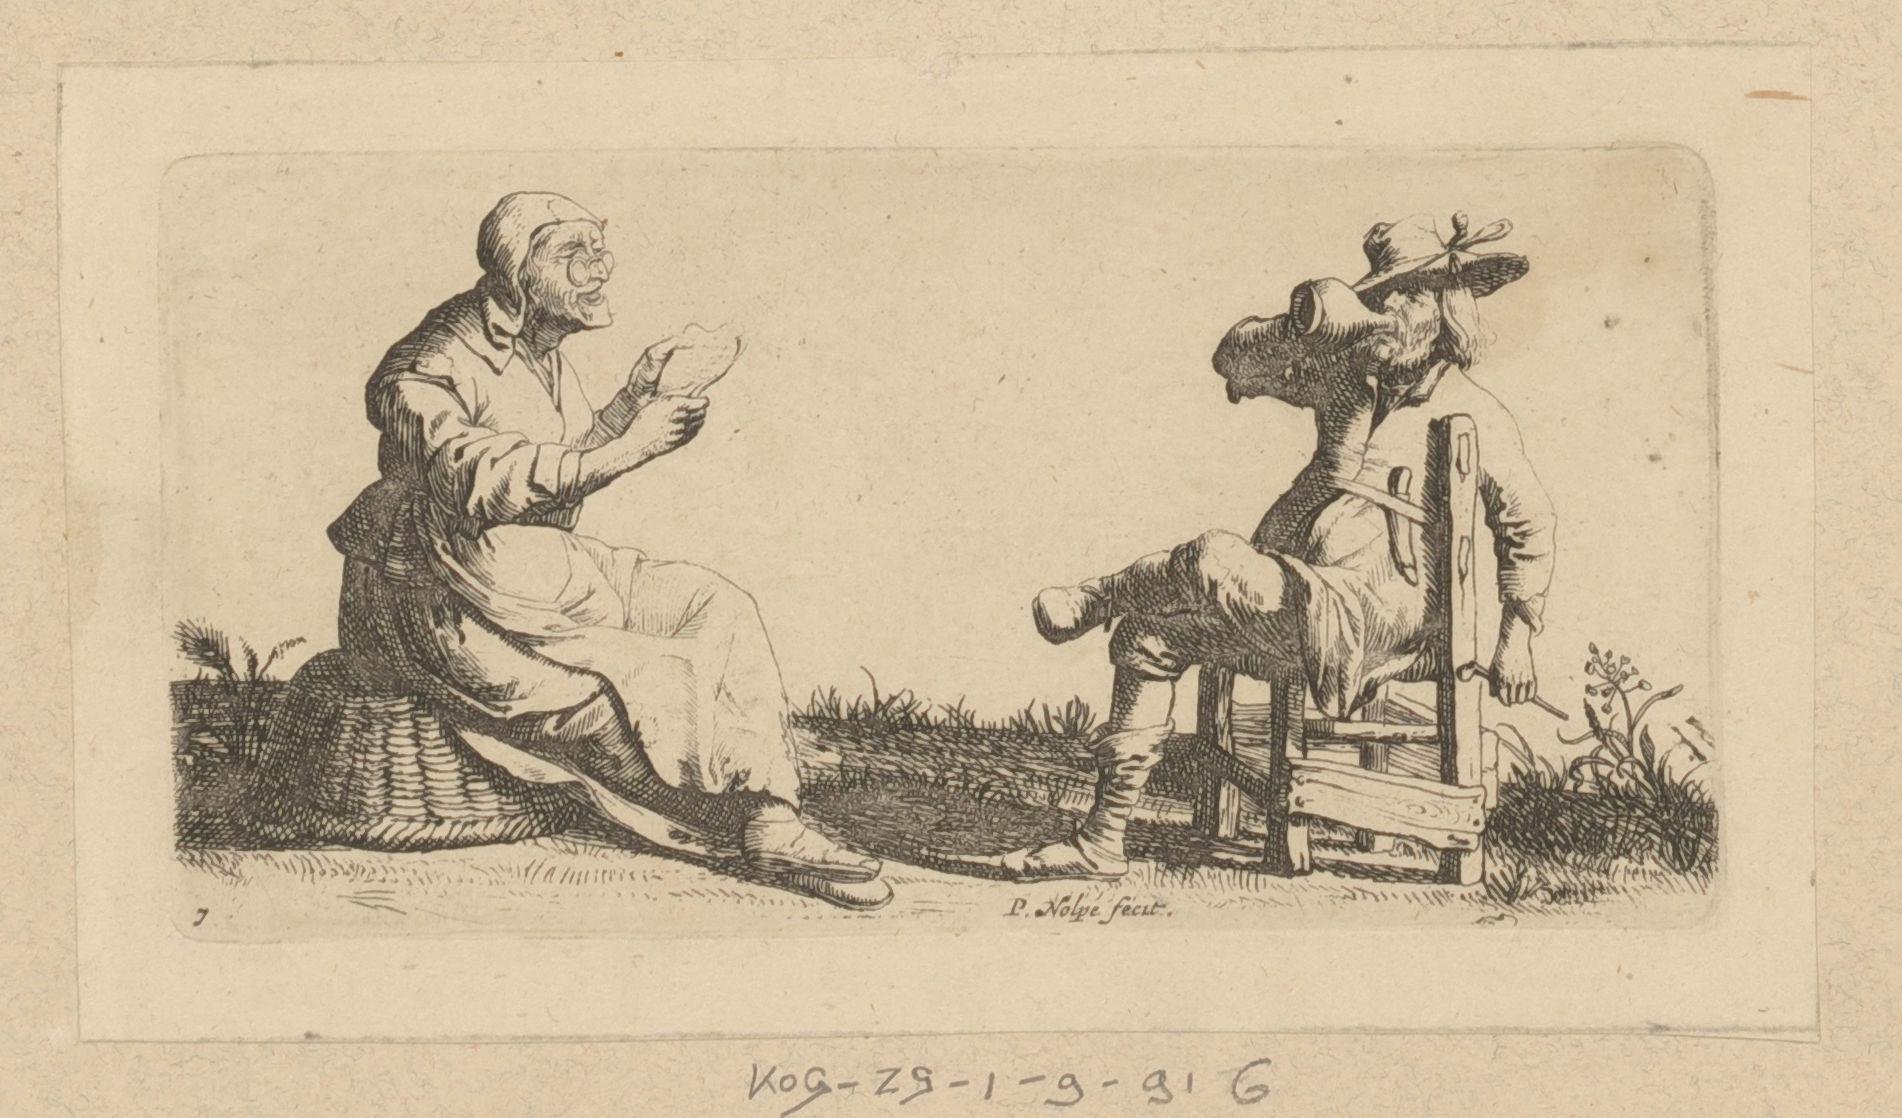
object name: print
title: Zittende boeren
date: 1633-1679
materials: paper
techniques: engraving, etching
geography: amsterdam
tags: farmers, drinking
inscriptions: collector's mark: Lugt 963, stamp:, collector's mark: Lugt 1641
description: Een boerin zit op een omgekeerde mand en leest met een bril op haar neus van het papier wat ze in haar handen houdt. Tegenover haar zit een boer op een stoel met een pijp in de hand. Hij zet een kruik aan zijn mond. Onderwerpsrubrieken binnen de Atlas Zeden en Gewoonten: Handel, nijverheid en verkeer, Boerenleven.